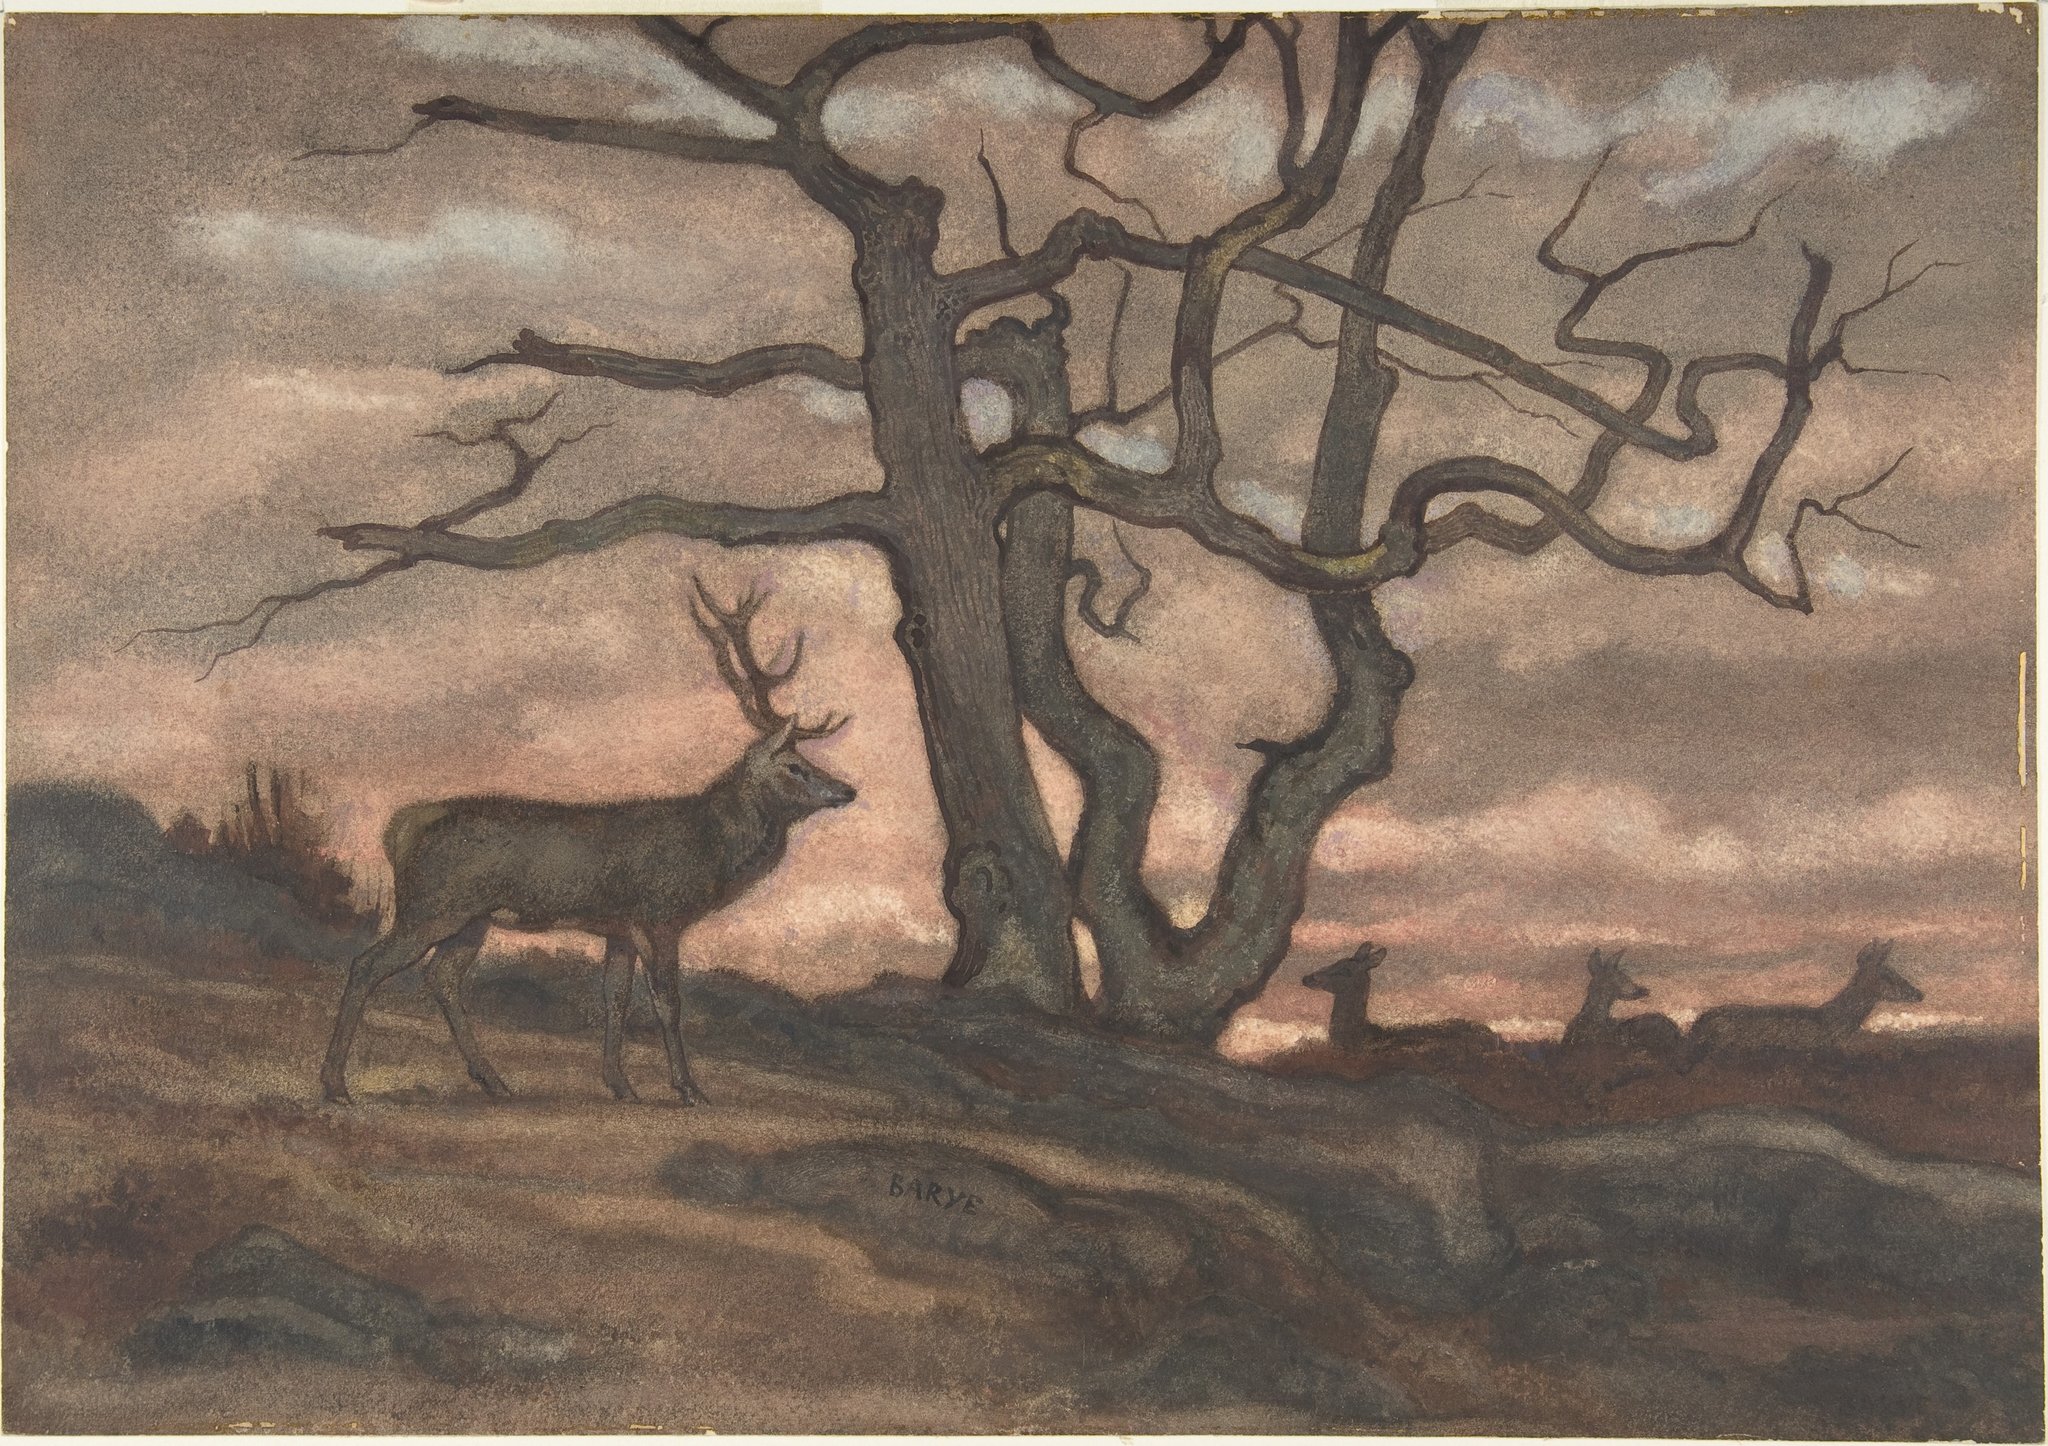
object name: drawing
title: Deer and Tree Against Sunset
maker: antoine-louis barye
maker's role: artist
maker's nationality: french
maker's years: 1795-1875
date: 1810-1875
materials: watercolor, paper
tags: deer,trees,evening